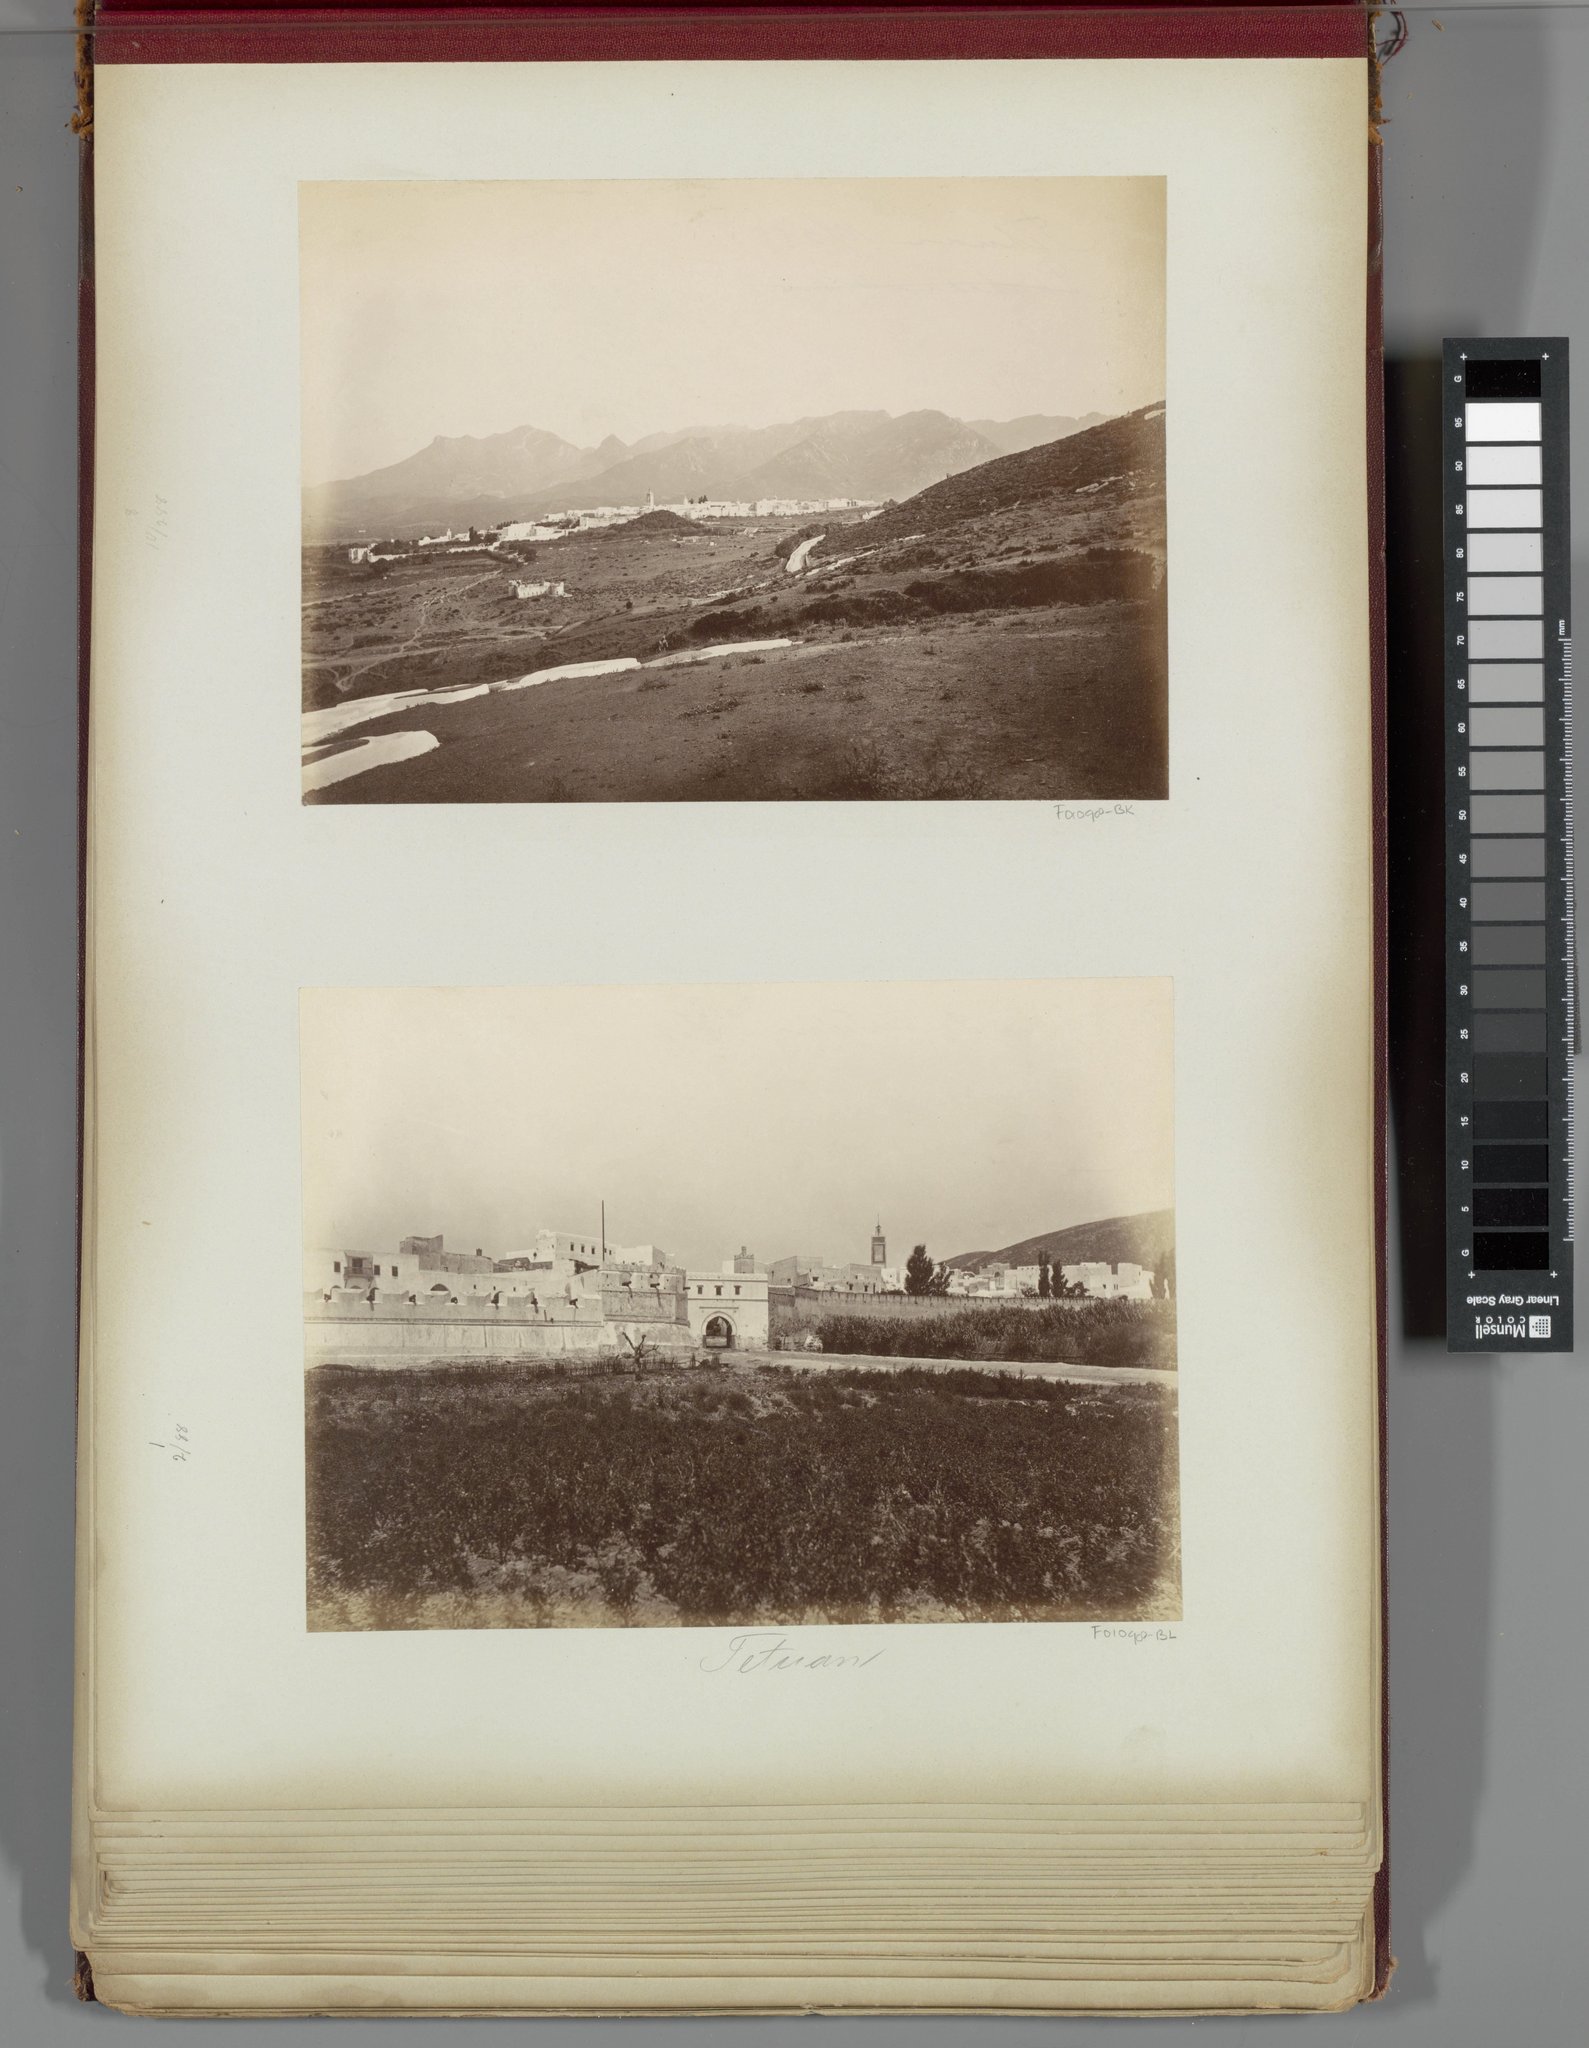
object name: photograph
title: Gezicht op een stad met bergen op de achtergrond, mogelijk Tétouan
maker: antonio cavilla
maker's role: fotograaf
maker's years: 1867-1908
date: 1880-1910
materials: cardboard, paper, photographic support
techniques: albumen print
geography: north africa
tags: mountain-range, snow peaks, prospect of city, town panorama, silhouette of city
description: Onderdeel van Reisalbum met foto's van bezienswaardigheden in Spanje en Marokko.